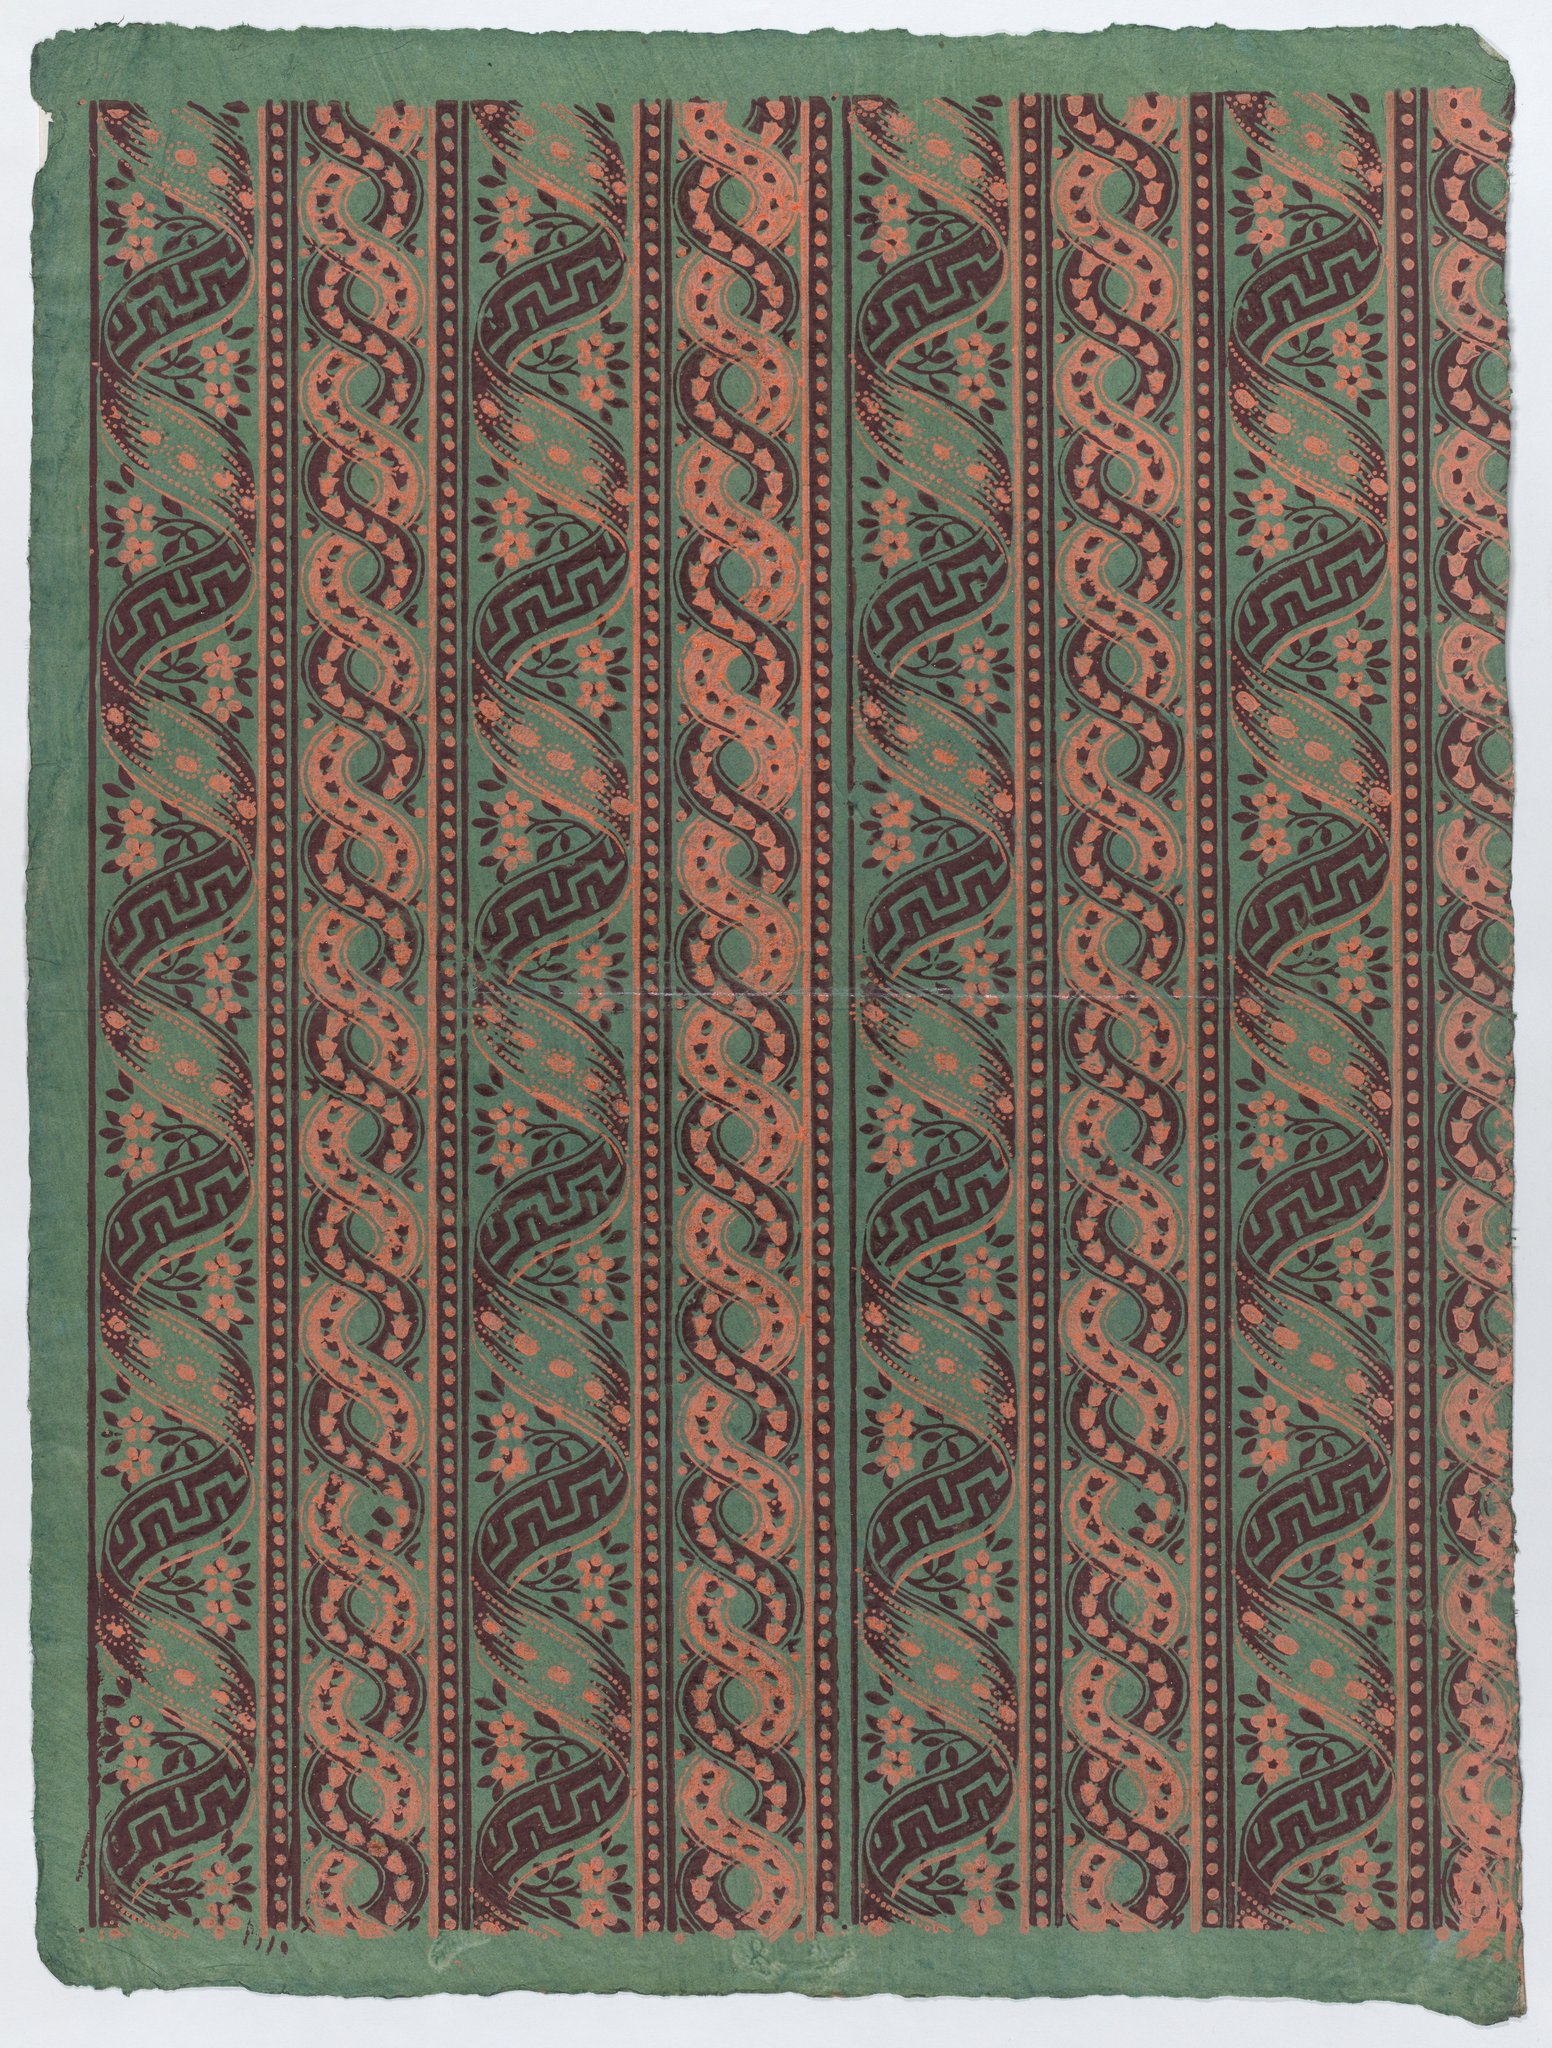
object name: print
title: Sheet with four borders with guilloche and ribbon patterns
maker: Anonymous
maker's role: artist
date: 1767-1866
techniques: relief print